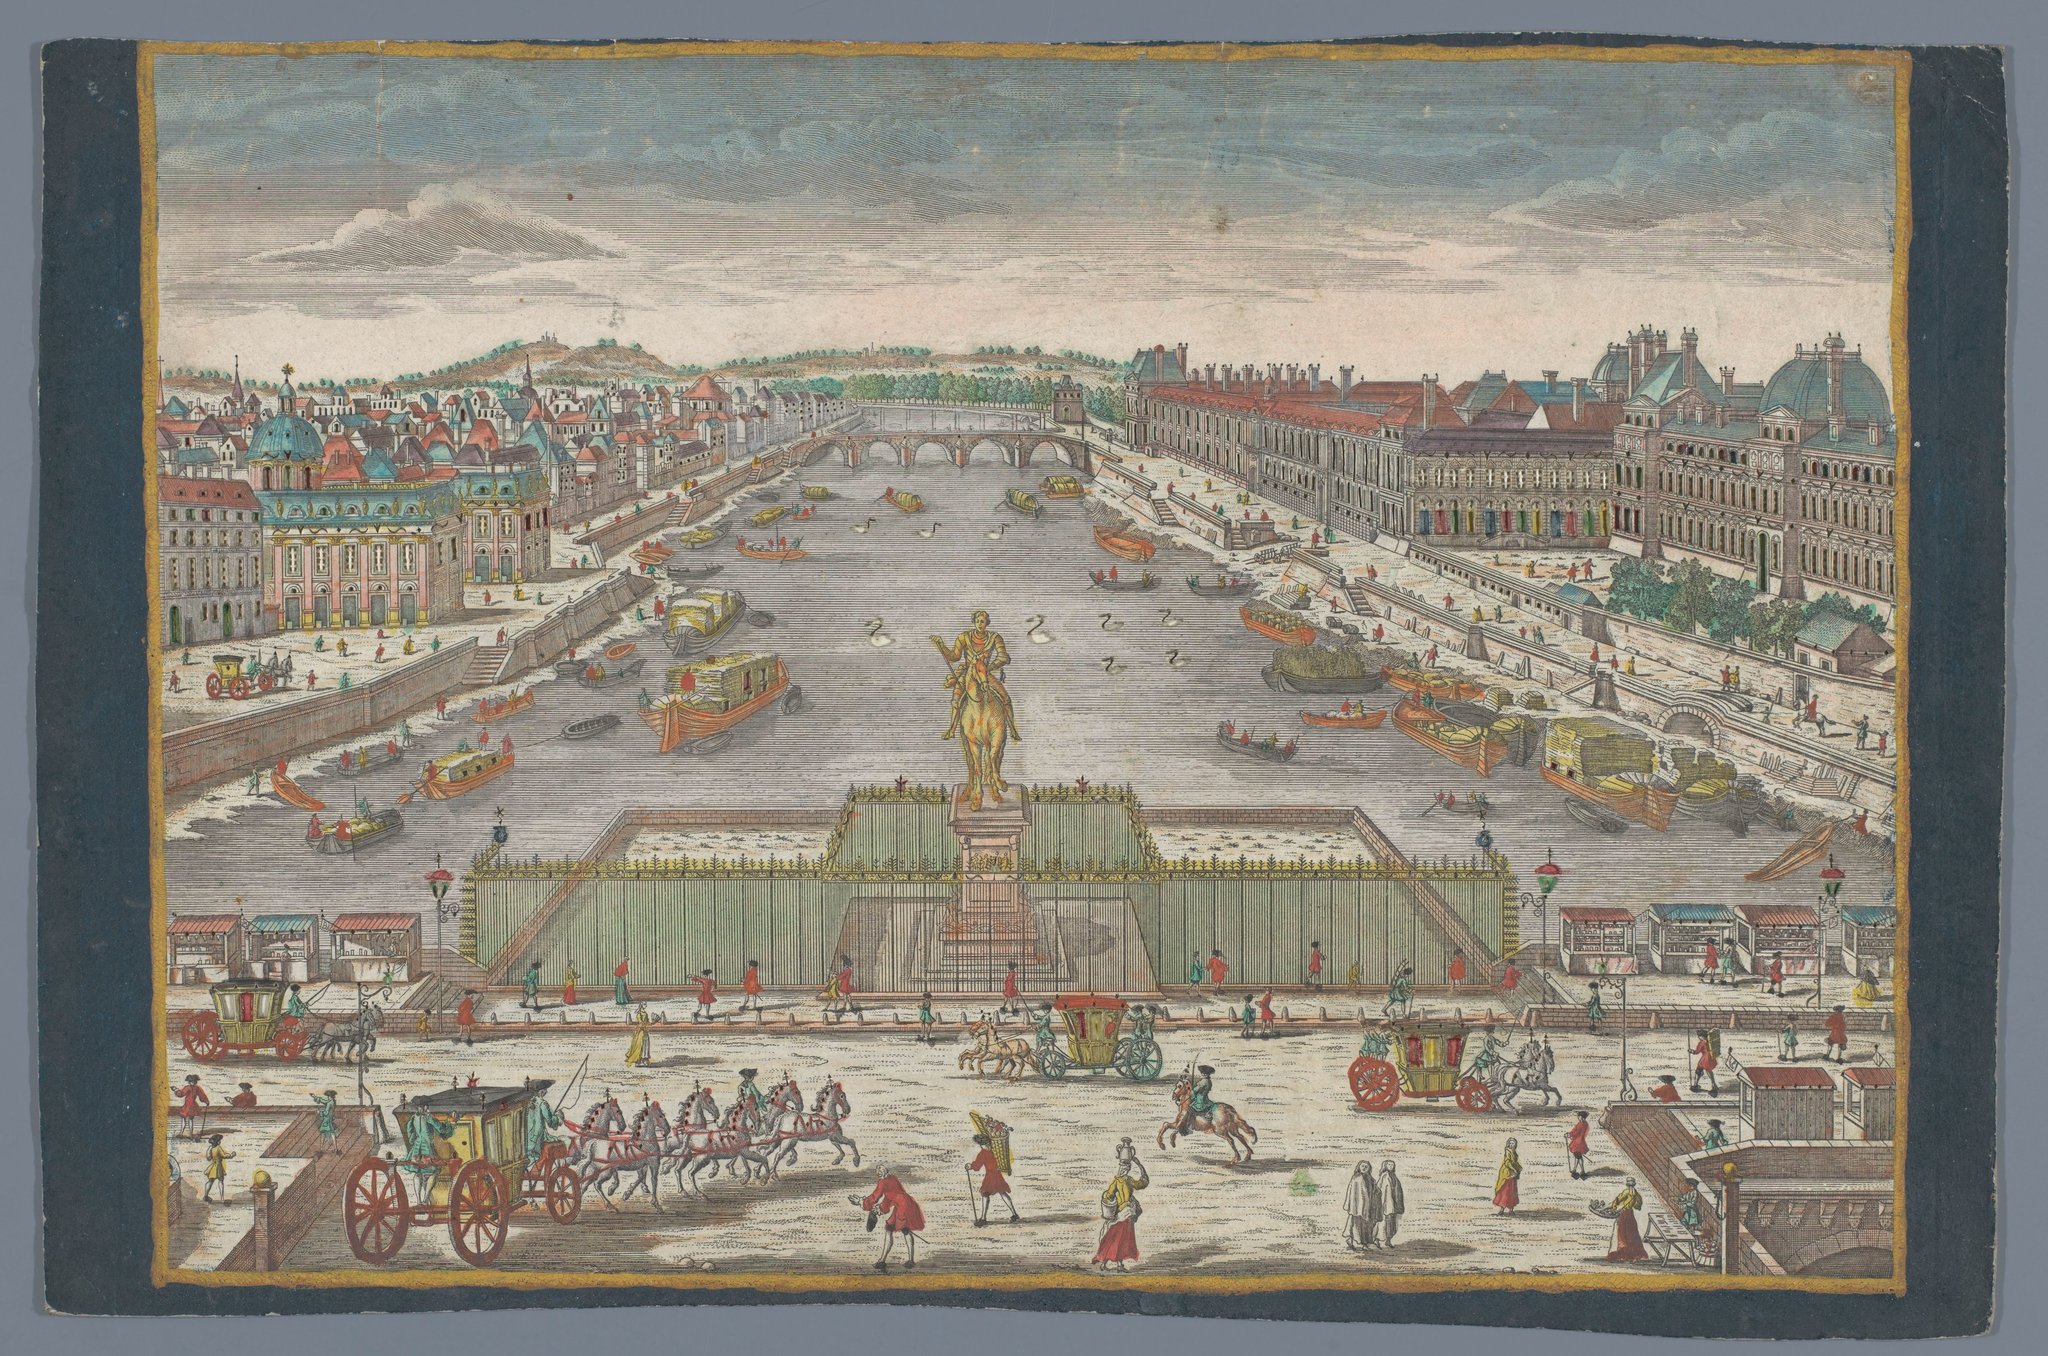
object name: print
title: Gezicht op de Pont Neuf over de rivier de Seine te Parijs, gezien richting de Pont Royal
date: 1742-1801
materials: cardboard, paint, paper, watercolor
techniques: brush, cutting, etching, perforating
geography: augsburg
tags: bridge in city across river, canal, etc. (+ city(-scape) with figures, staffage), rowing-boat, canoe, etc., equestrian statue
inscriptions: collector's mark: Lugt 2233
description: Mogelijk rechtsboven genummerd geweest: 36. Mogelijk linksonder genummerd geweest: 22. De serie “Parijs”, met het nummer 22, bevat zes prenten met de nummers 35-40, waarvan dit mogelijk nummer 36 is.